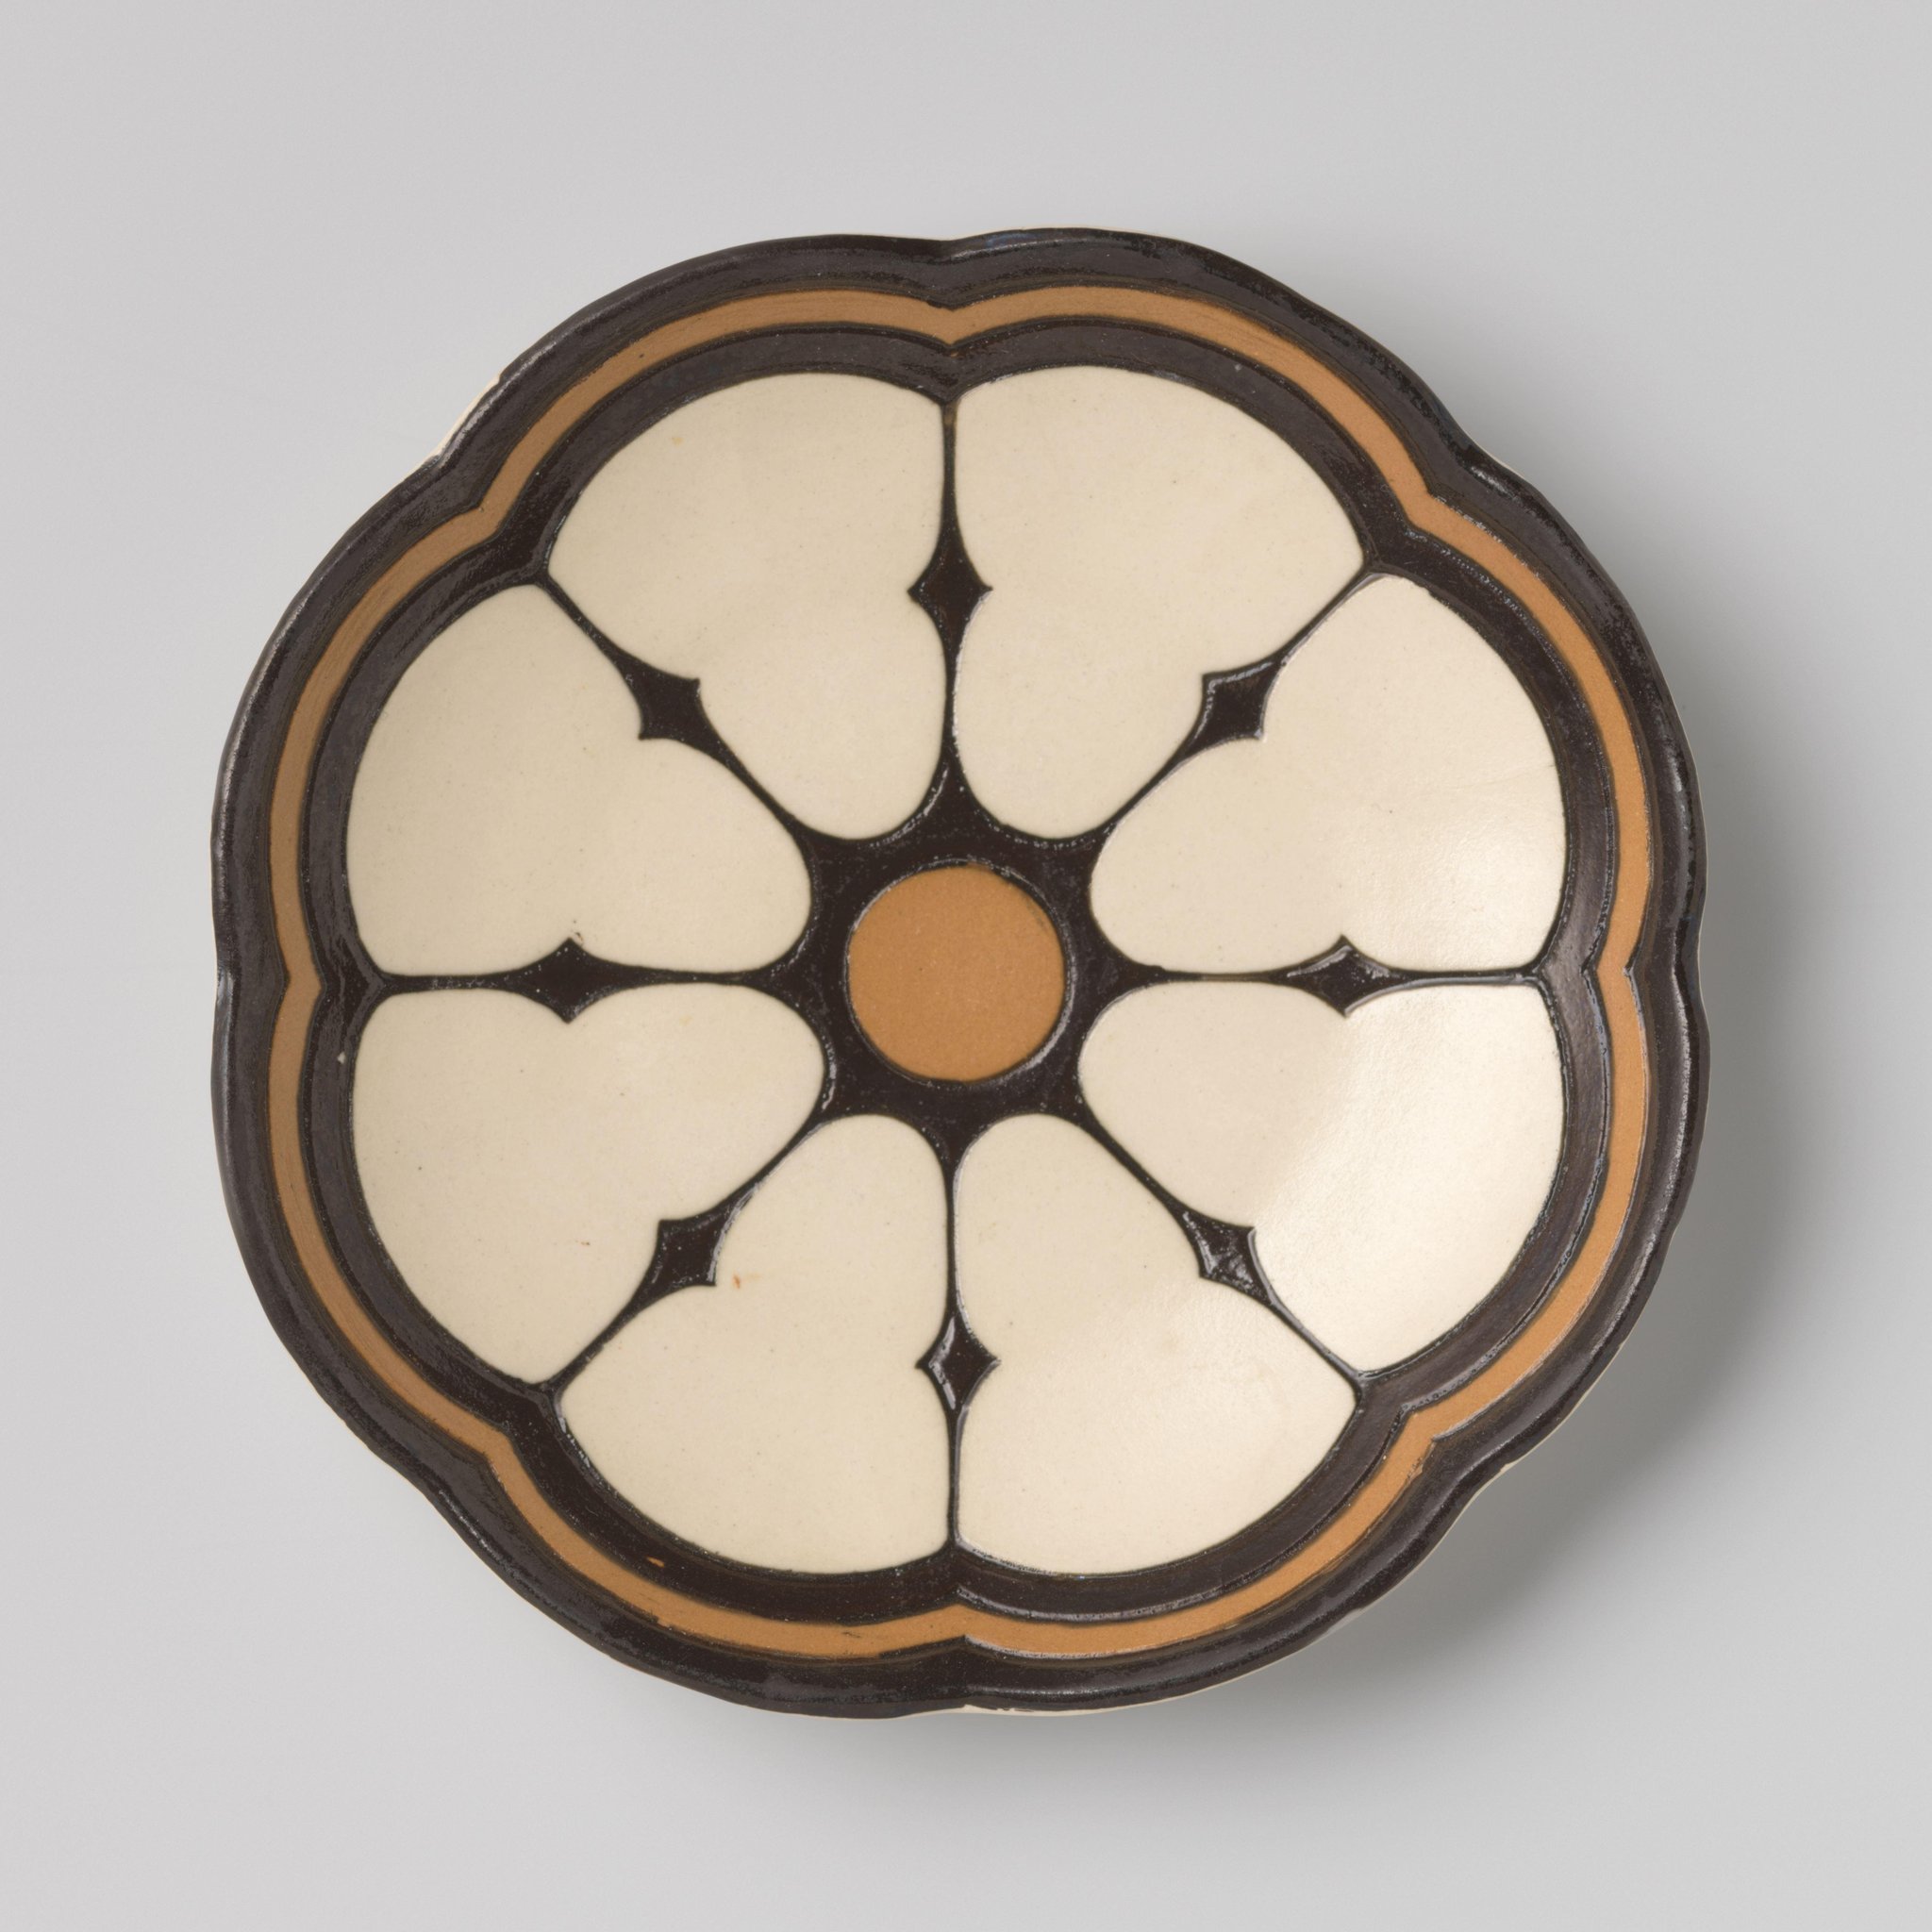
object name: platter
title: Schotel versierd met decor in zwart en bruin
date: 1906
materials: stoneware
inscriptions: mark: ‘METTLACH // VB in een naamplaat ; 23 GES.GESCH 06. en vormnr. 3060’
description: Schotel van chromolith-steengoed, versierd in zwart en bruin met een decor dat op een wiel met spaken lijkt (of een bloemkelk in reliëf).